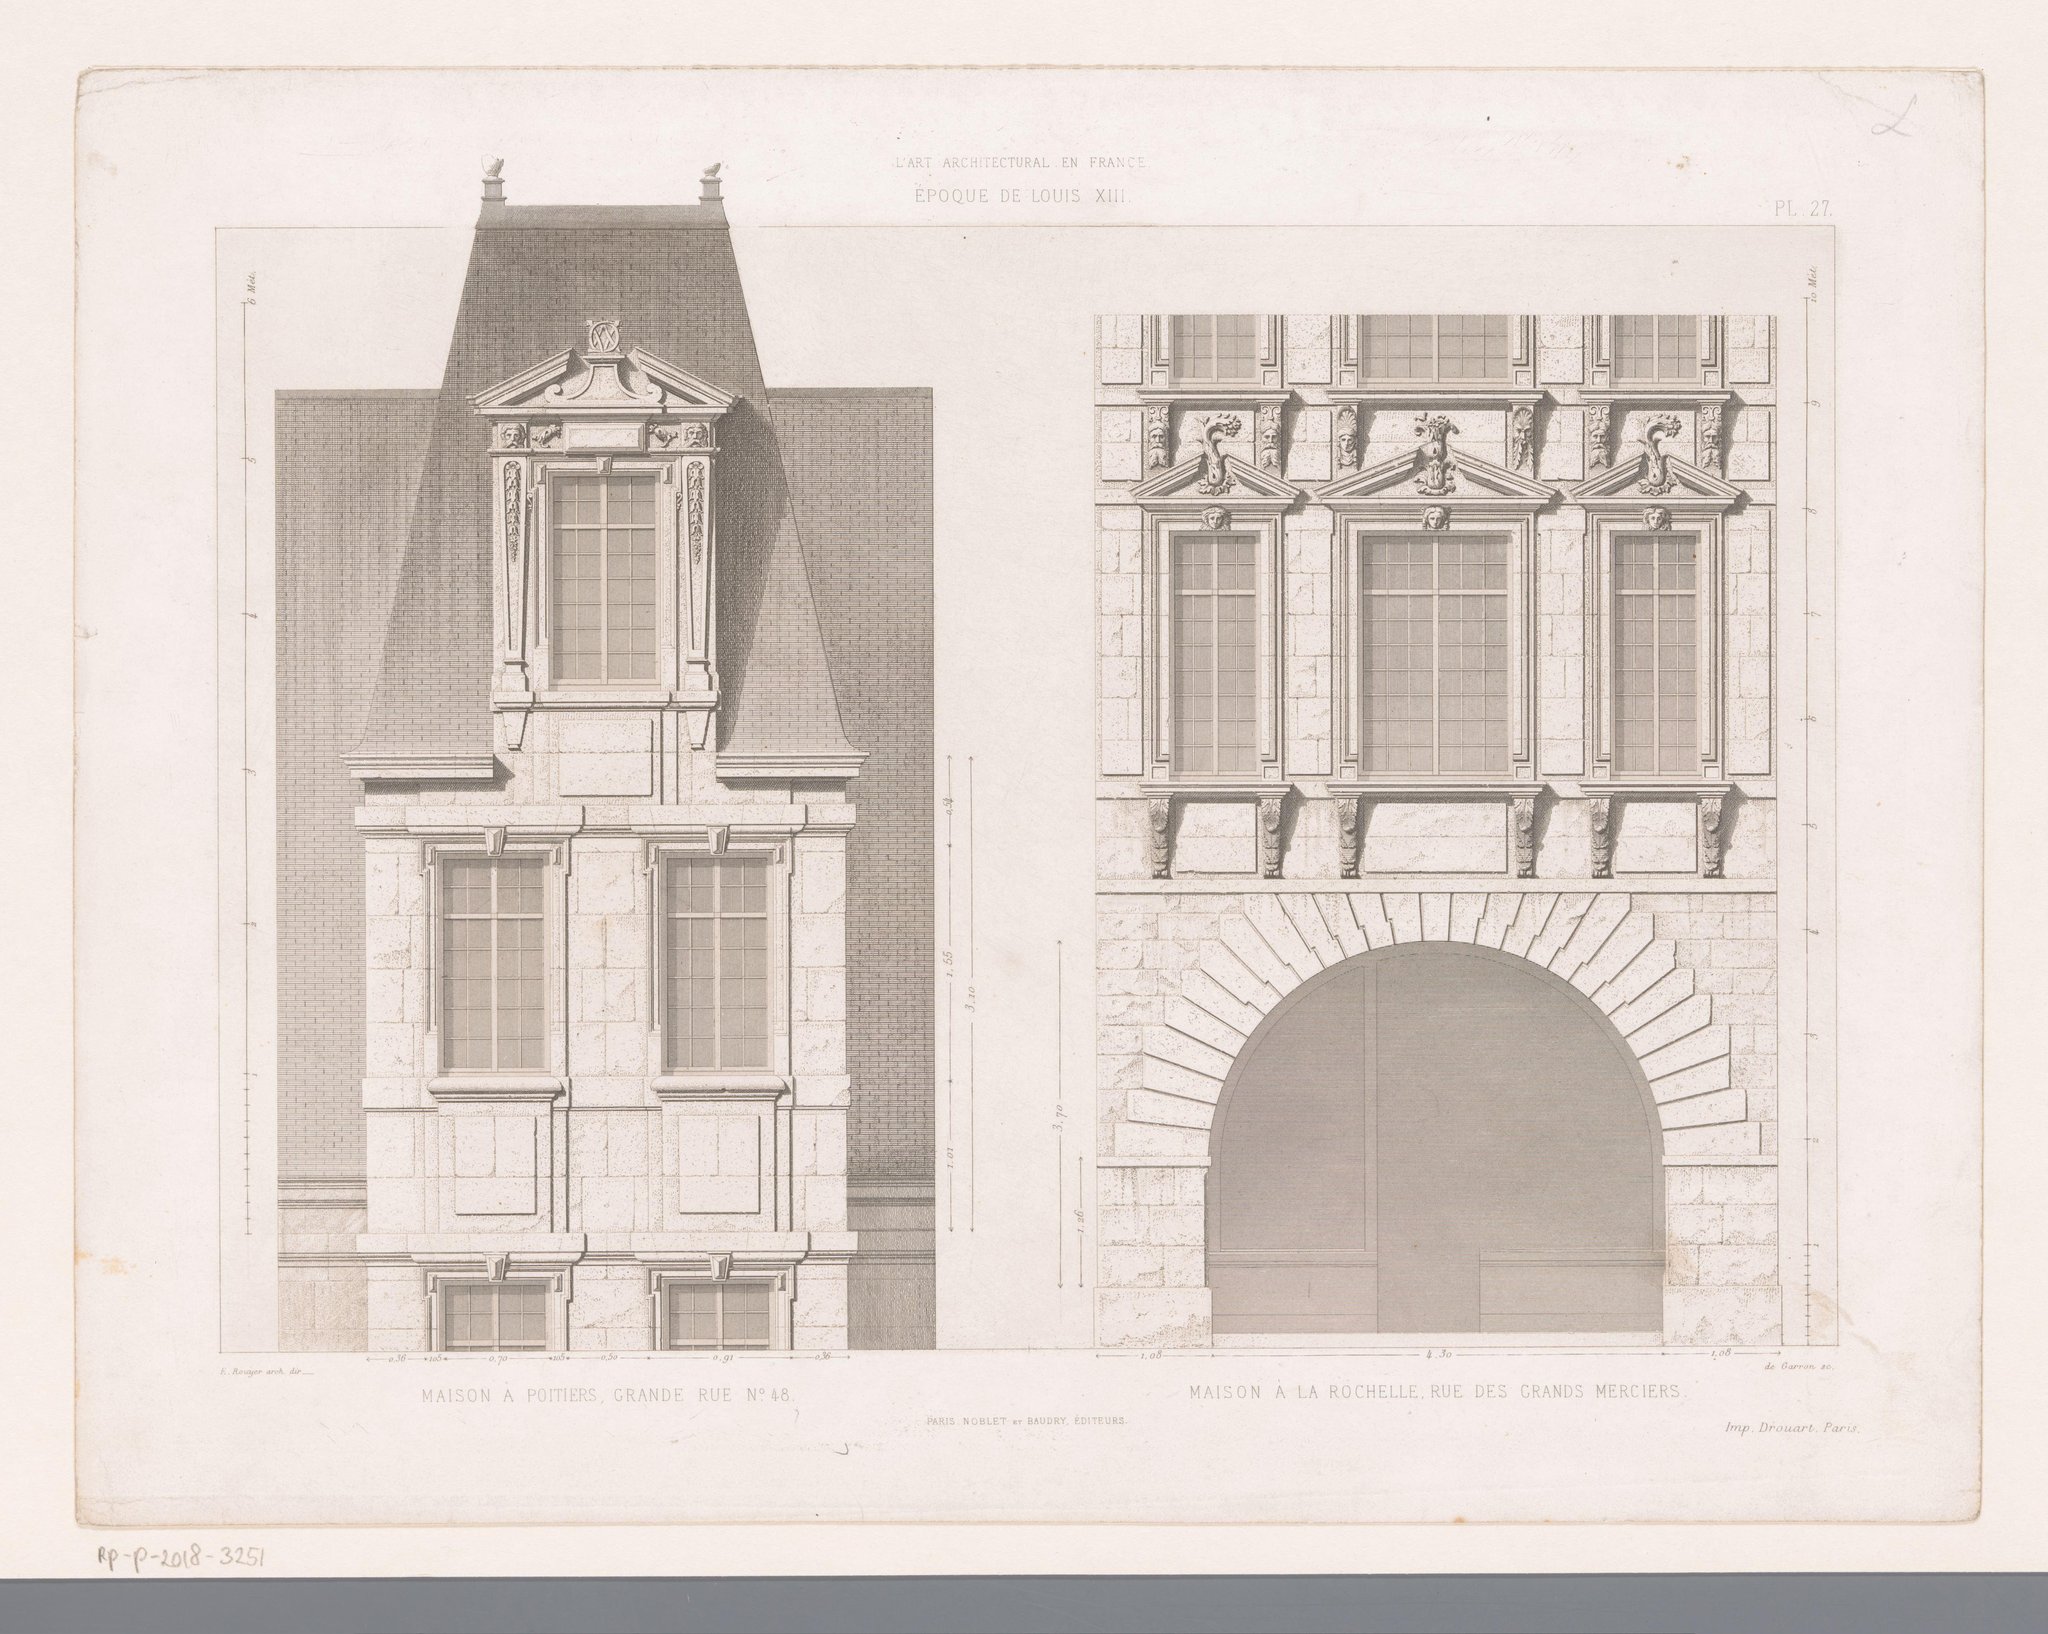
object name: print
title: Gezicht op twee huizen in Poitiers en La Rochelle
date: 1863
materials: paper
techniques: lithograph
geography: paris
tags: architectural detail, civic architecture; edifices; dwellings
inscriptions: collector's mark: Lugt 2228, collector's mark: Lugt 3937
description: Prent uit: Darcel, Alfred. L'Art Architectural en France (...). Dl. 1. Parijs: Nobley et Baudry, 1863.